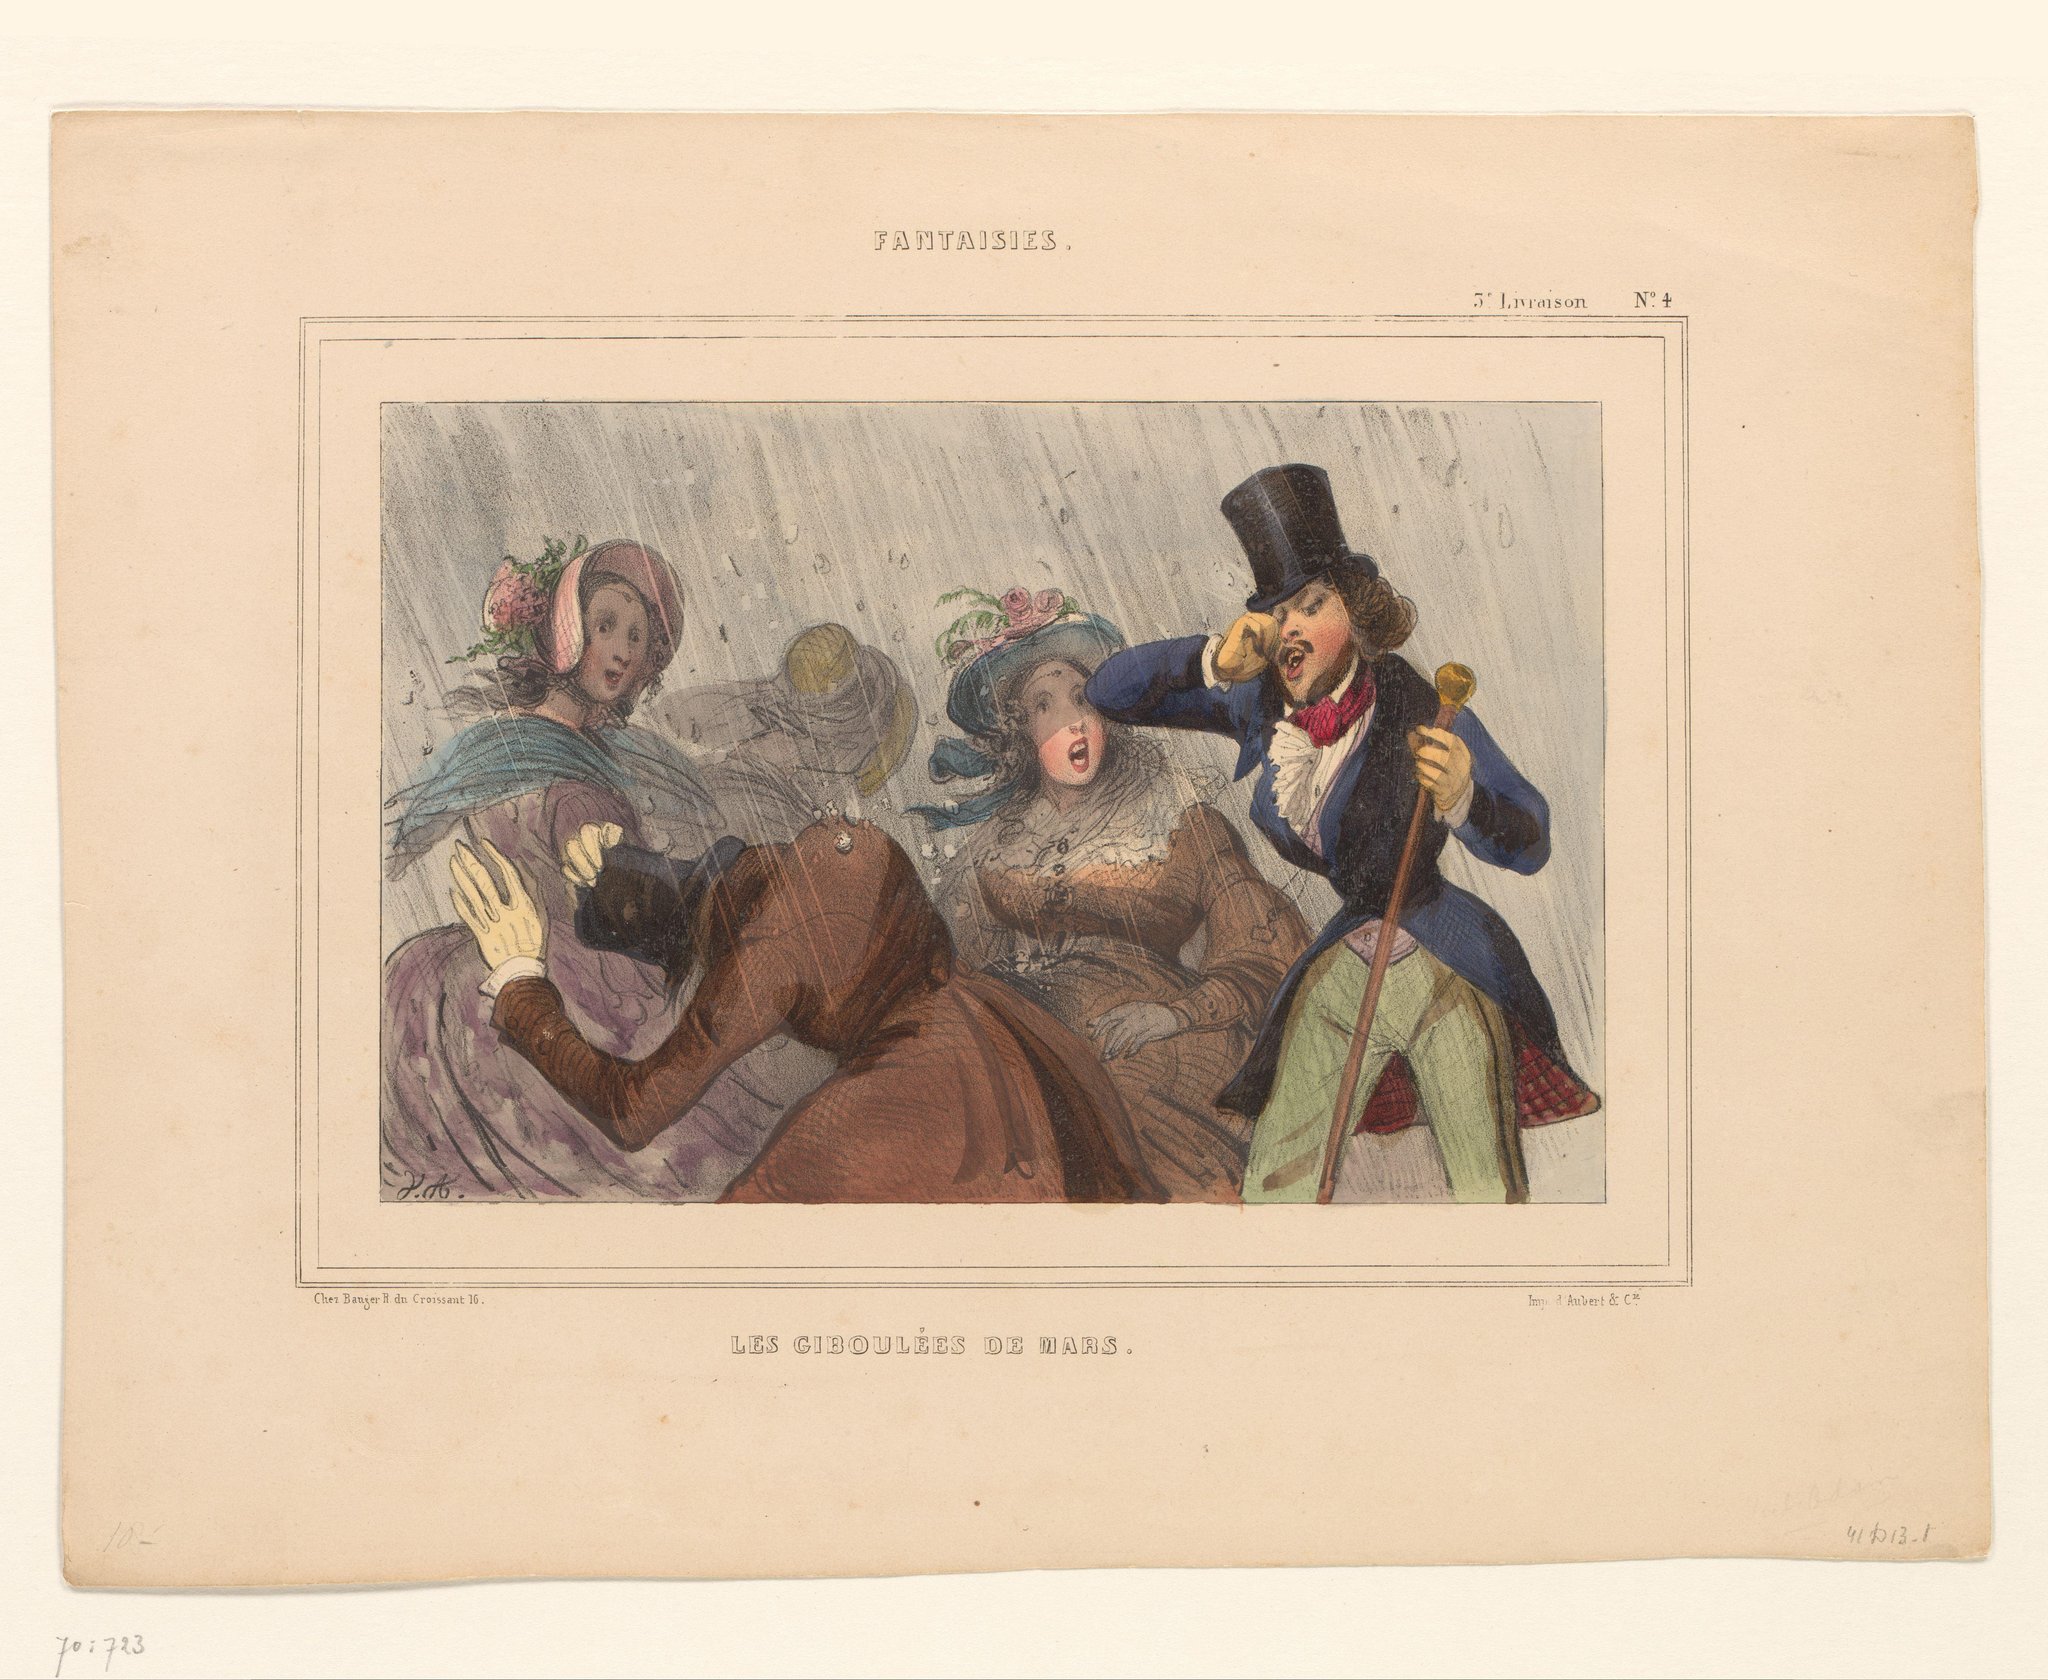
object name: print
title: Les Giboulées de Mars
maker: victor adam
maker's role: painter, print maker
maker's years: 1801-1866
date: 1803-1839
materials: lacquer, paper, watercolor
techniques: hand coloring, lacquer, lithograph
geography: france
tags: hail, march ~ other concepts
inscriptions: collector's mark: Lugt 2228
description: Een aantal modieus geklede personen wordt getroffen door een maartse hagelbui. Rechtsboven genummerd: 3e Livraison No. 4.